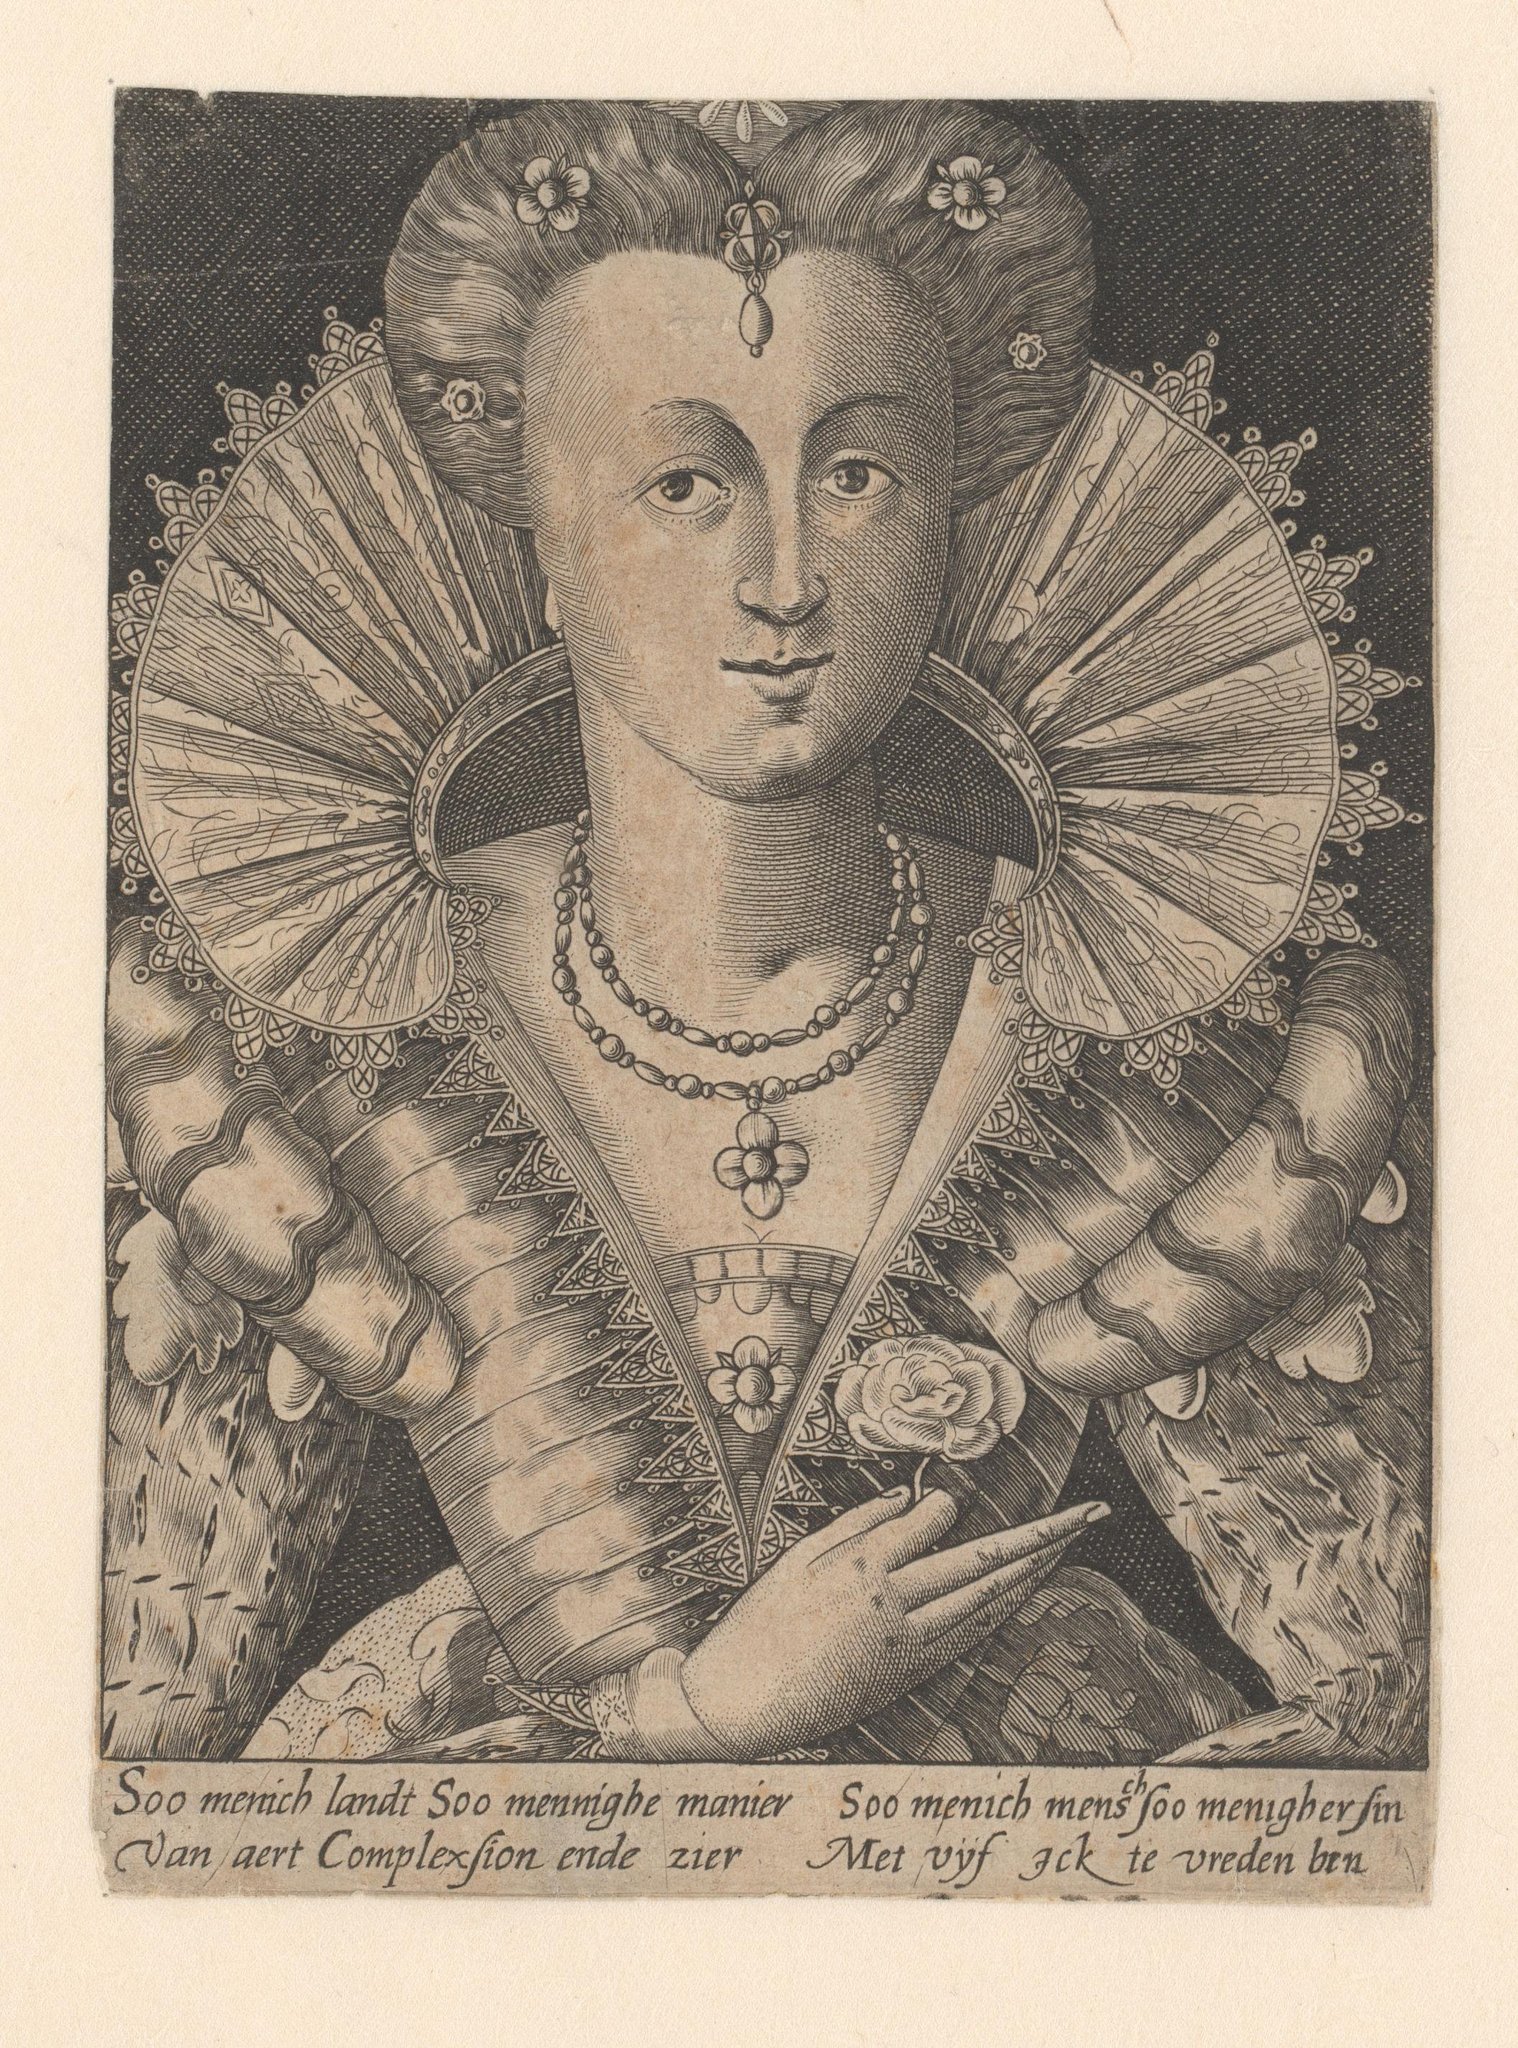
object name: print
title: Vijf zintuigen gepersonifieerd door vrouwen in modieuze kostuums en met kapsels uit verschillende landen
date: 1590-1620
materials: paper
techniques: engraving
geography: low countries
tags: styles of hairdress - aa - ~ women, fashion, smell, smelling (one of the five senses) - aa - female human figure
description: Zintuig Reuk. Modieuze jonge vrouw met een roos. Prent uit een serie met vijf zintuigen, waarin de vijf zintuigen zijn gepersonifieerd door vrouwen in modieuze kostuums en met kapsels uit verschillende landen en voorzien van attributen. Met onderschrift in het Nederlands.